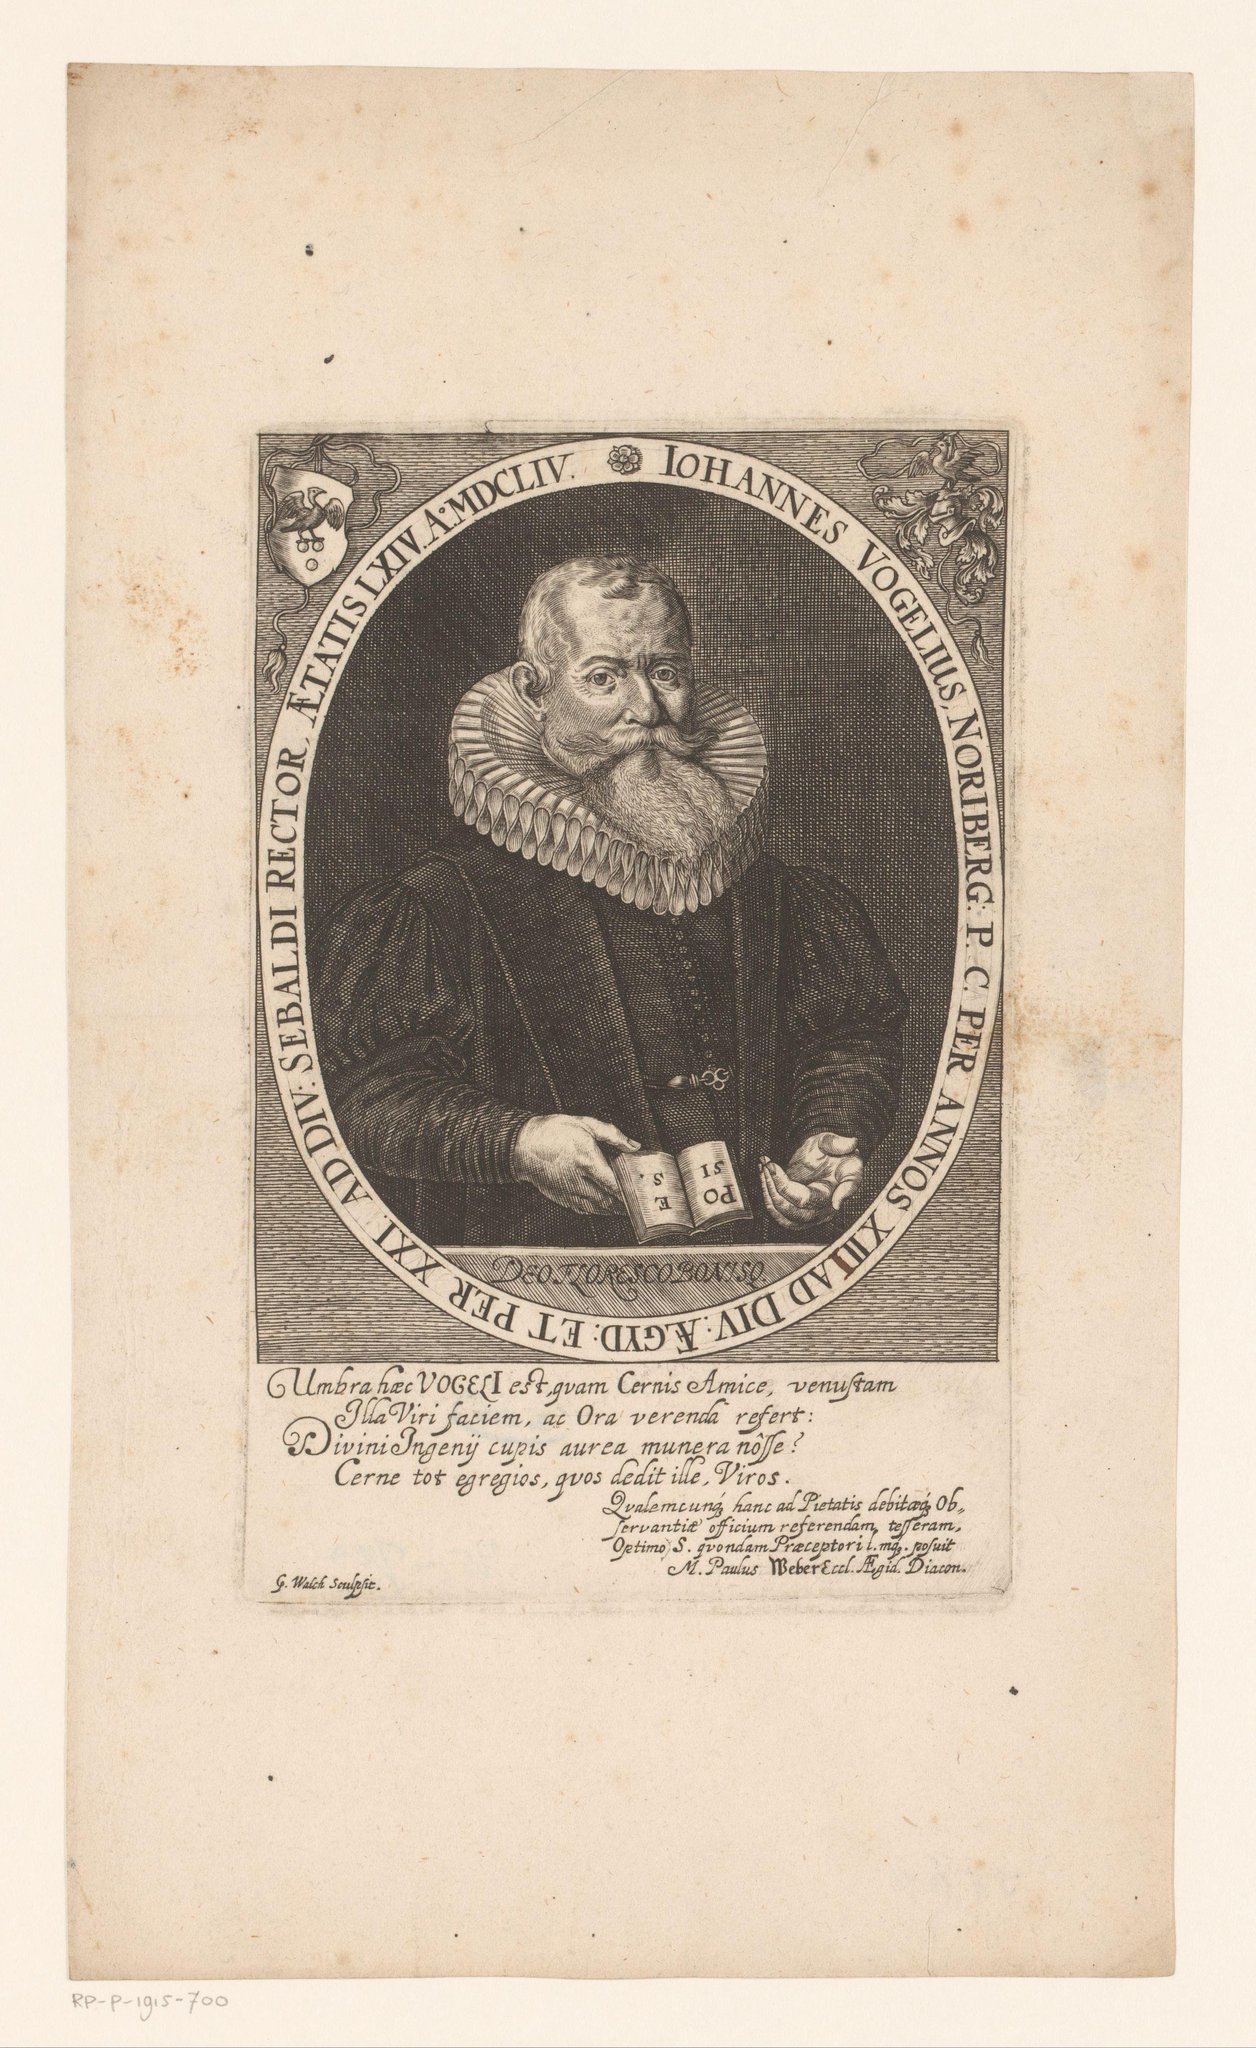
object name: print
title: Portret van Johann Vogel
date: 1635-1654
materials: paper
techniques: engraving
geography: germany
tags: johann vogel, historical persons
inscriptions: collector's mark: Lugt 2228